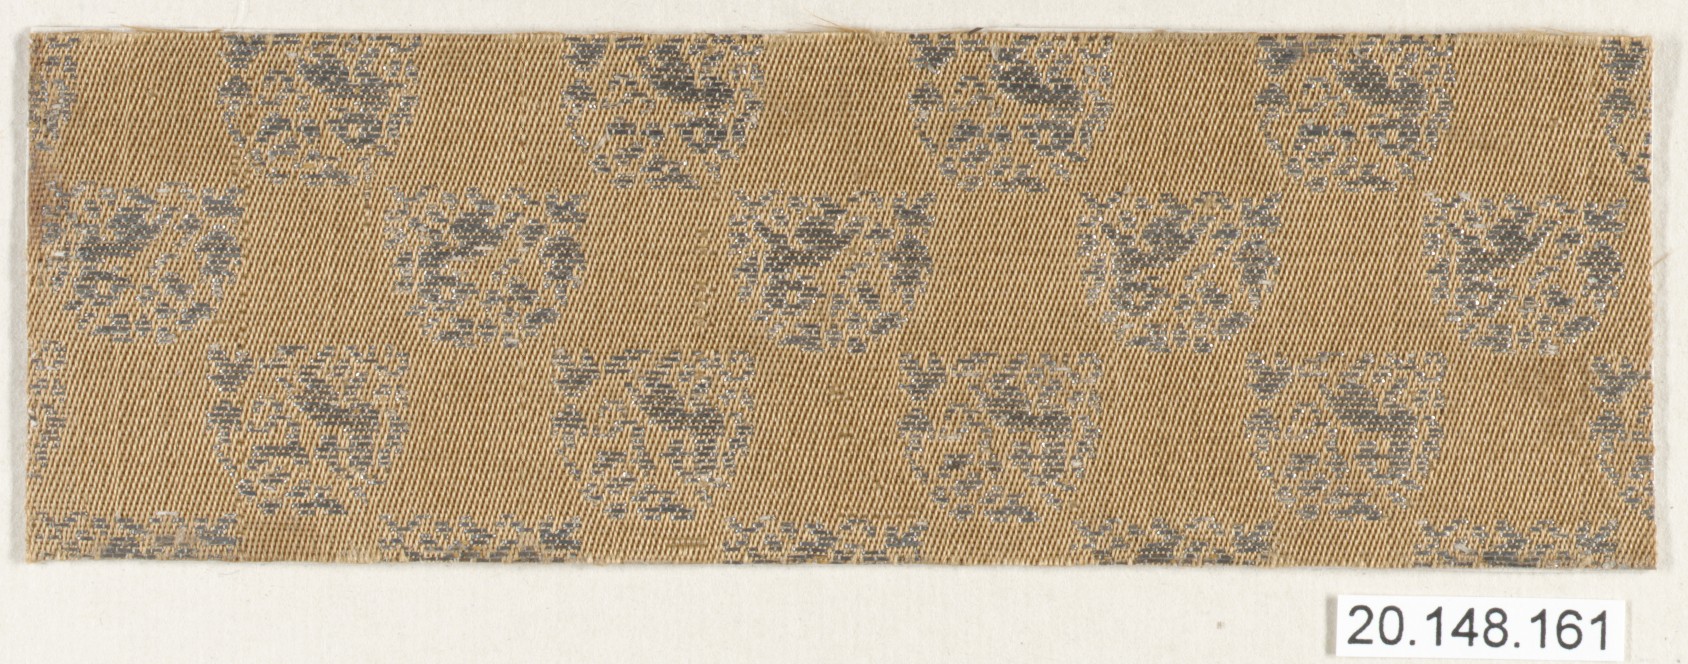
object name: piece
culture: japanese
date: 1701-1800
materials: silk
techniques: compound weave